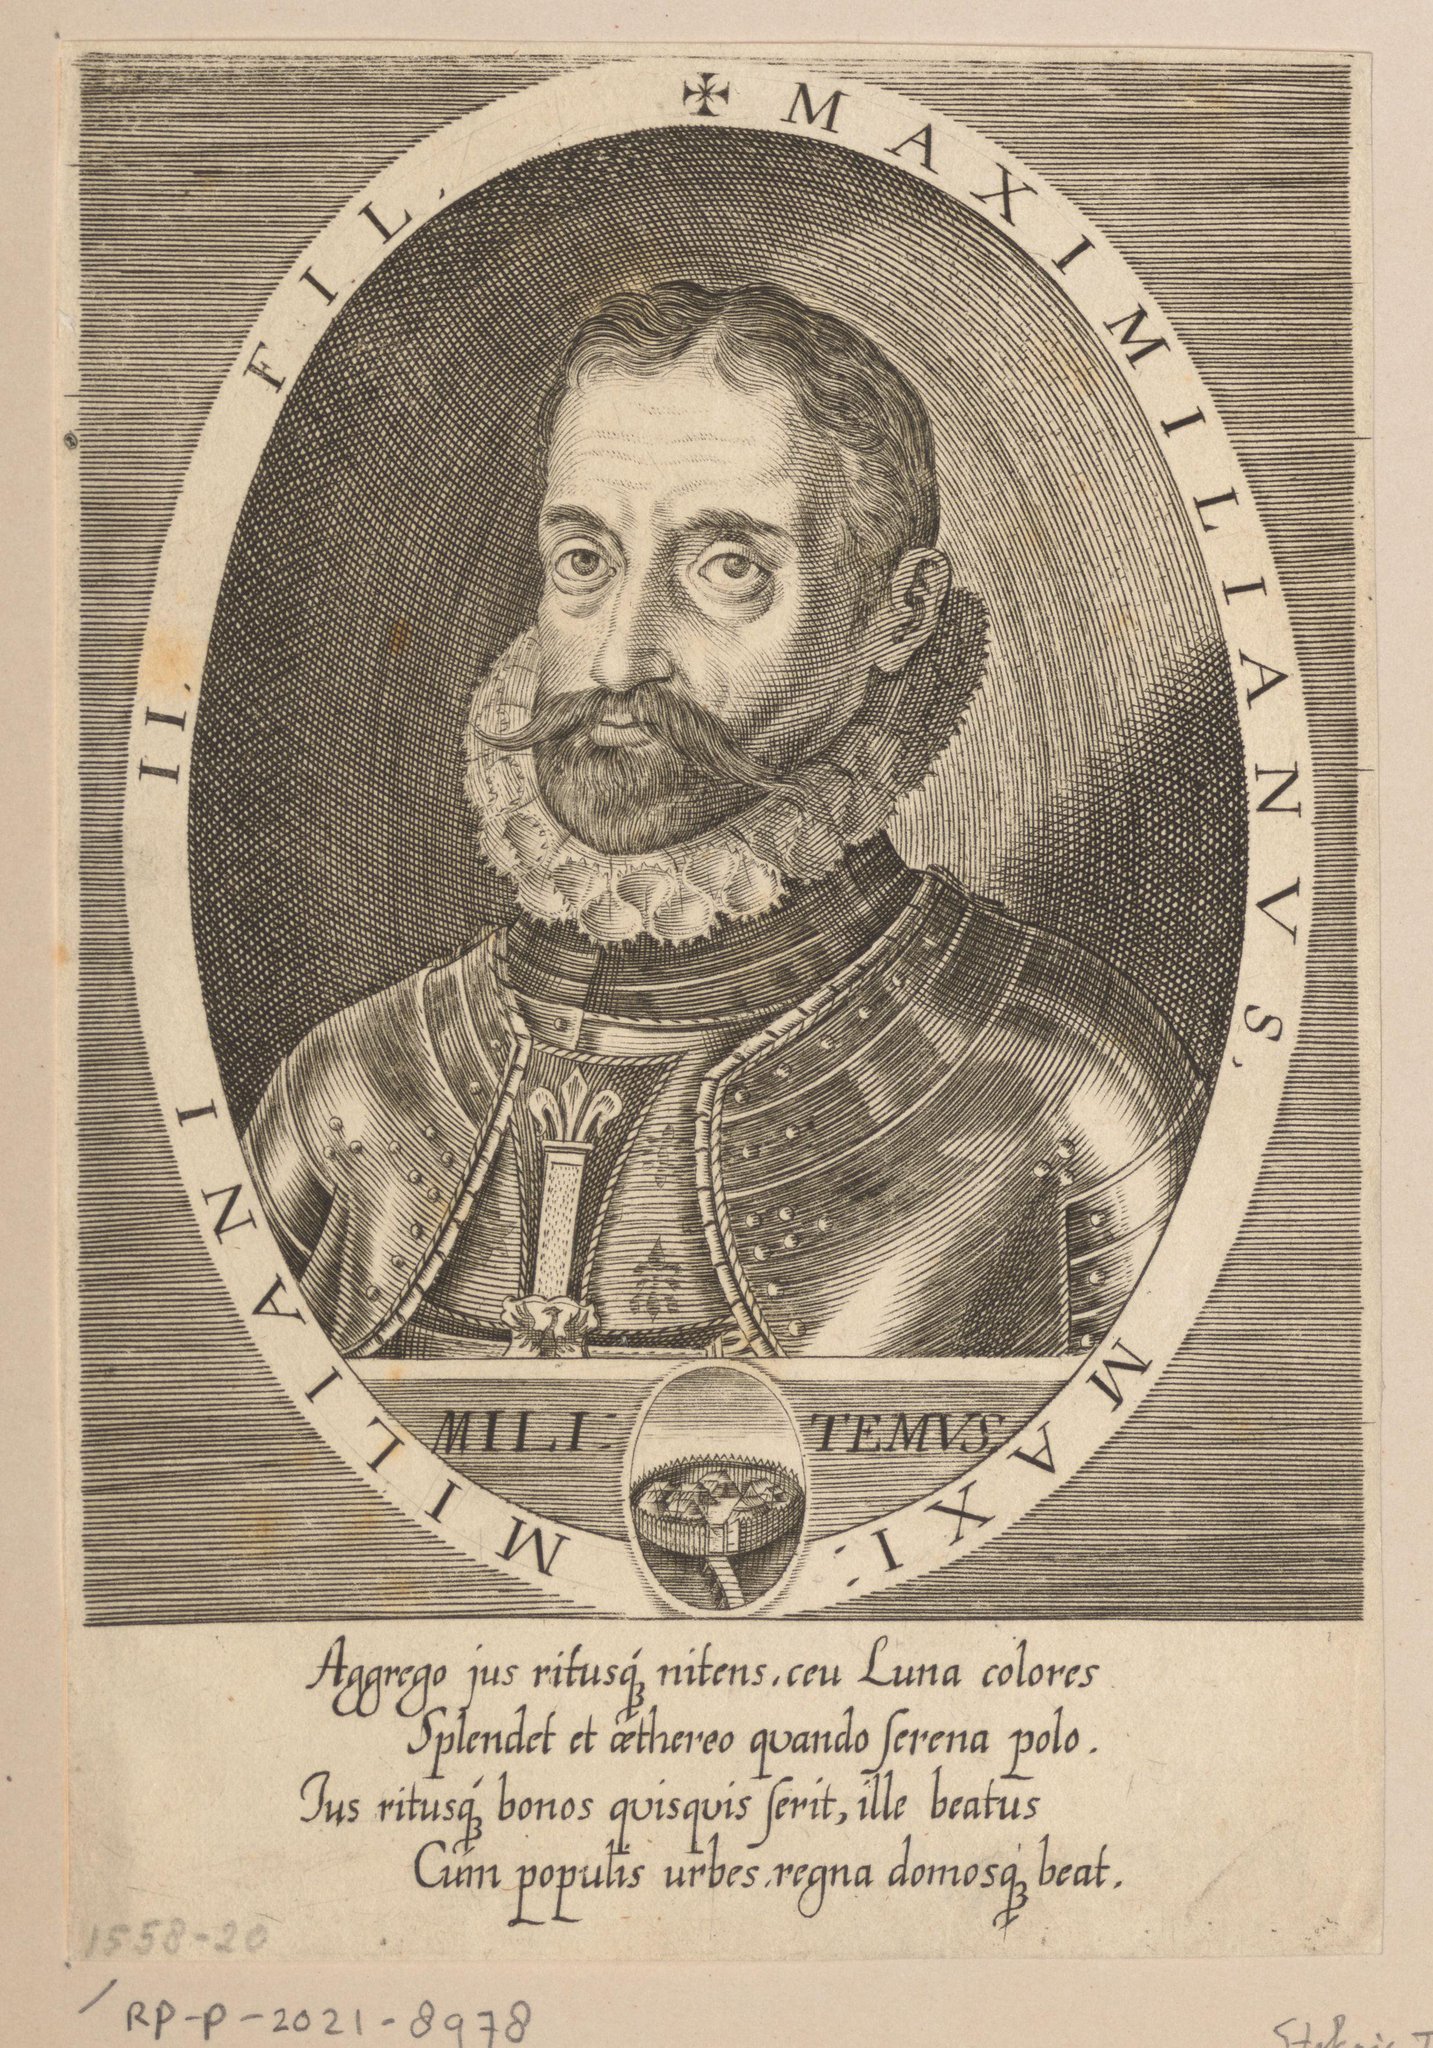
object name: print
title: Portret van Maximiliaan III van Oostenrijk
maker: wolfgang kilian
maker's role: print maker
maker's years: 1581-1662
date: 1623-1629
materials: paper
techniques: engraving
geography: augsburg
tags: maximiliaan iii (aartshertog van oostenrijk), ornament ~ medallion, armour, historical persons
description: Prent met tekst in boekdruk op verso gebruikt in: Serenissimorum Austriae Ducum Archiducum, Regum, Imperatorum (...). Augsburg: Lukas Schultes, 1623. En ook in de Duitse editie: Deß aller durchlauchtigsten Haus Österreich Herzogen, Ertzhertzogen, König und Kayser (...). Augsburg: s.n., 1629.